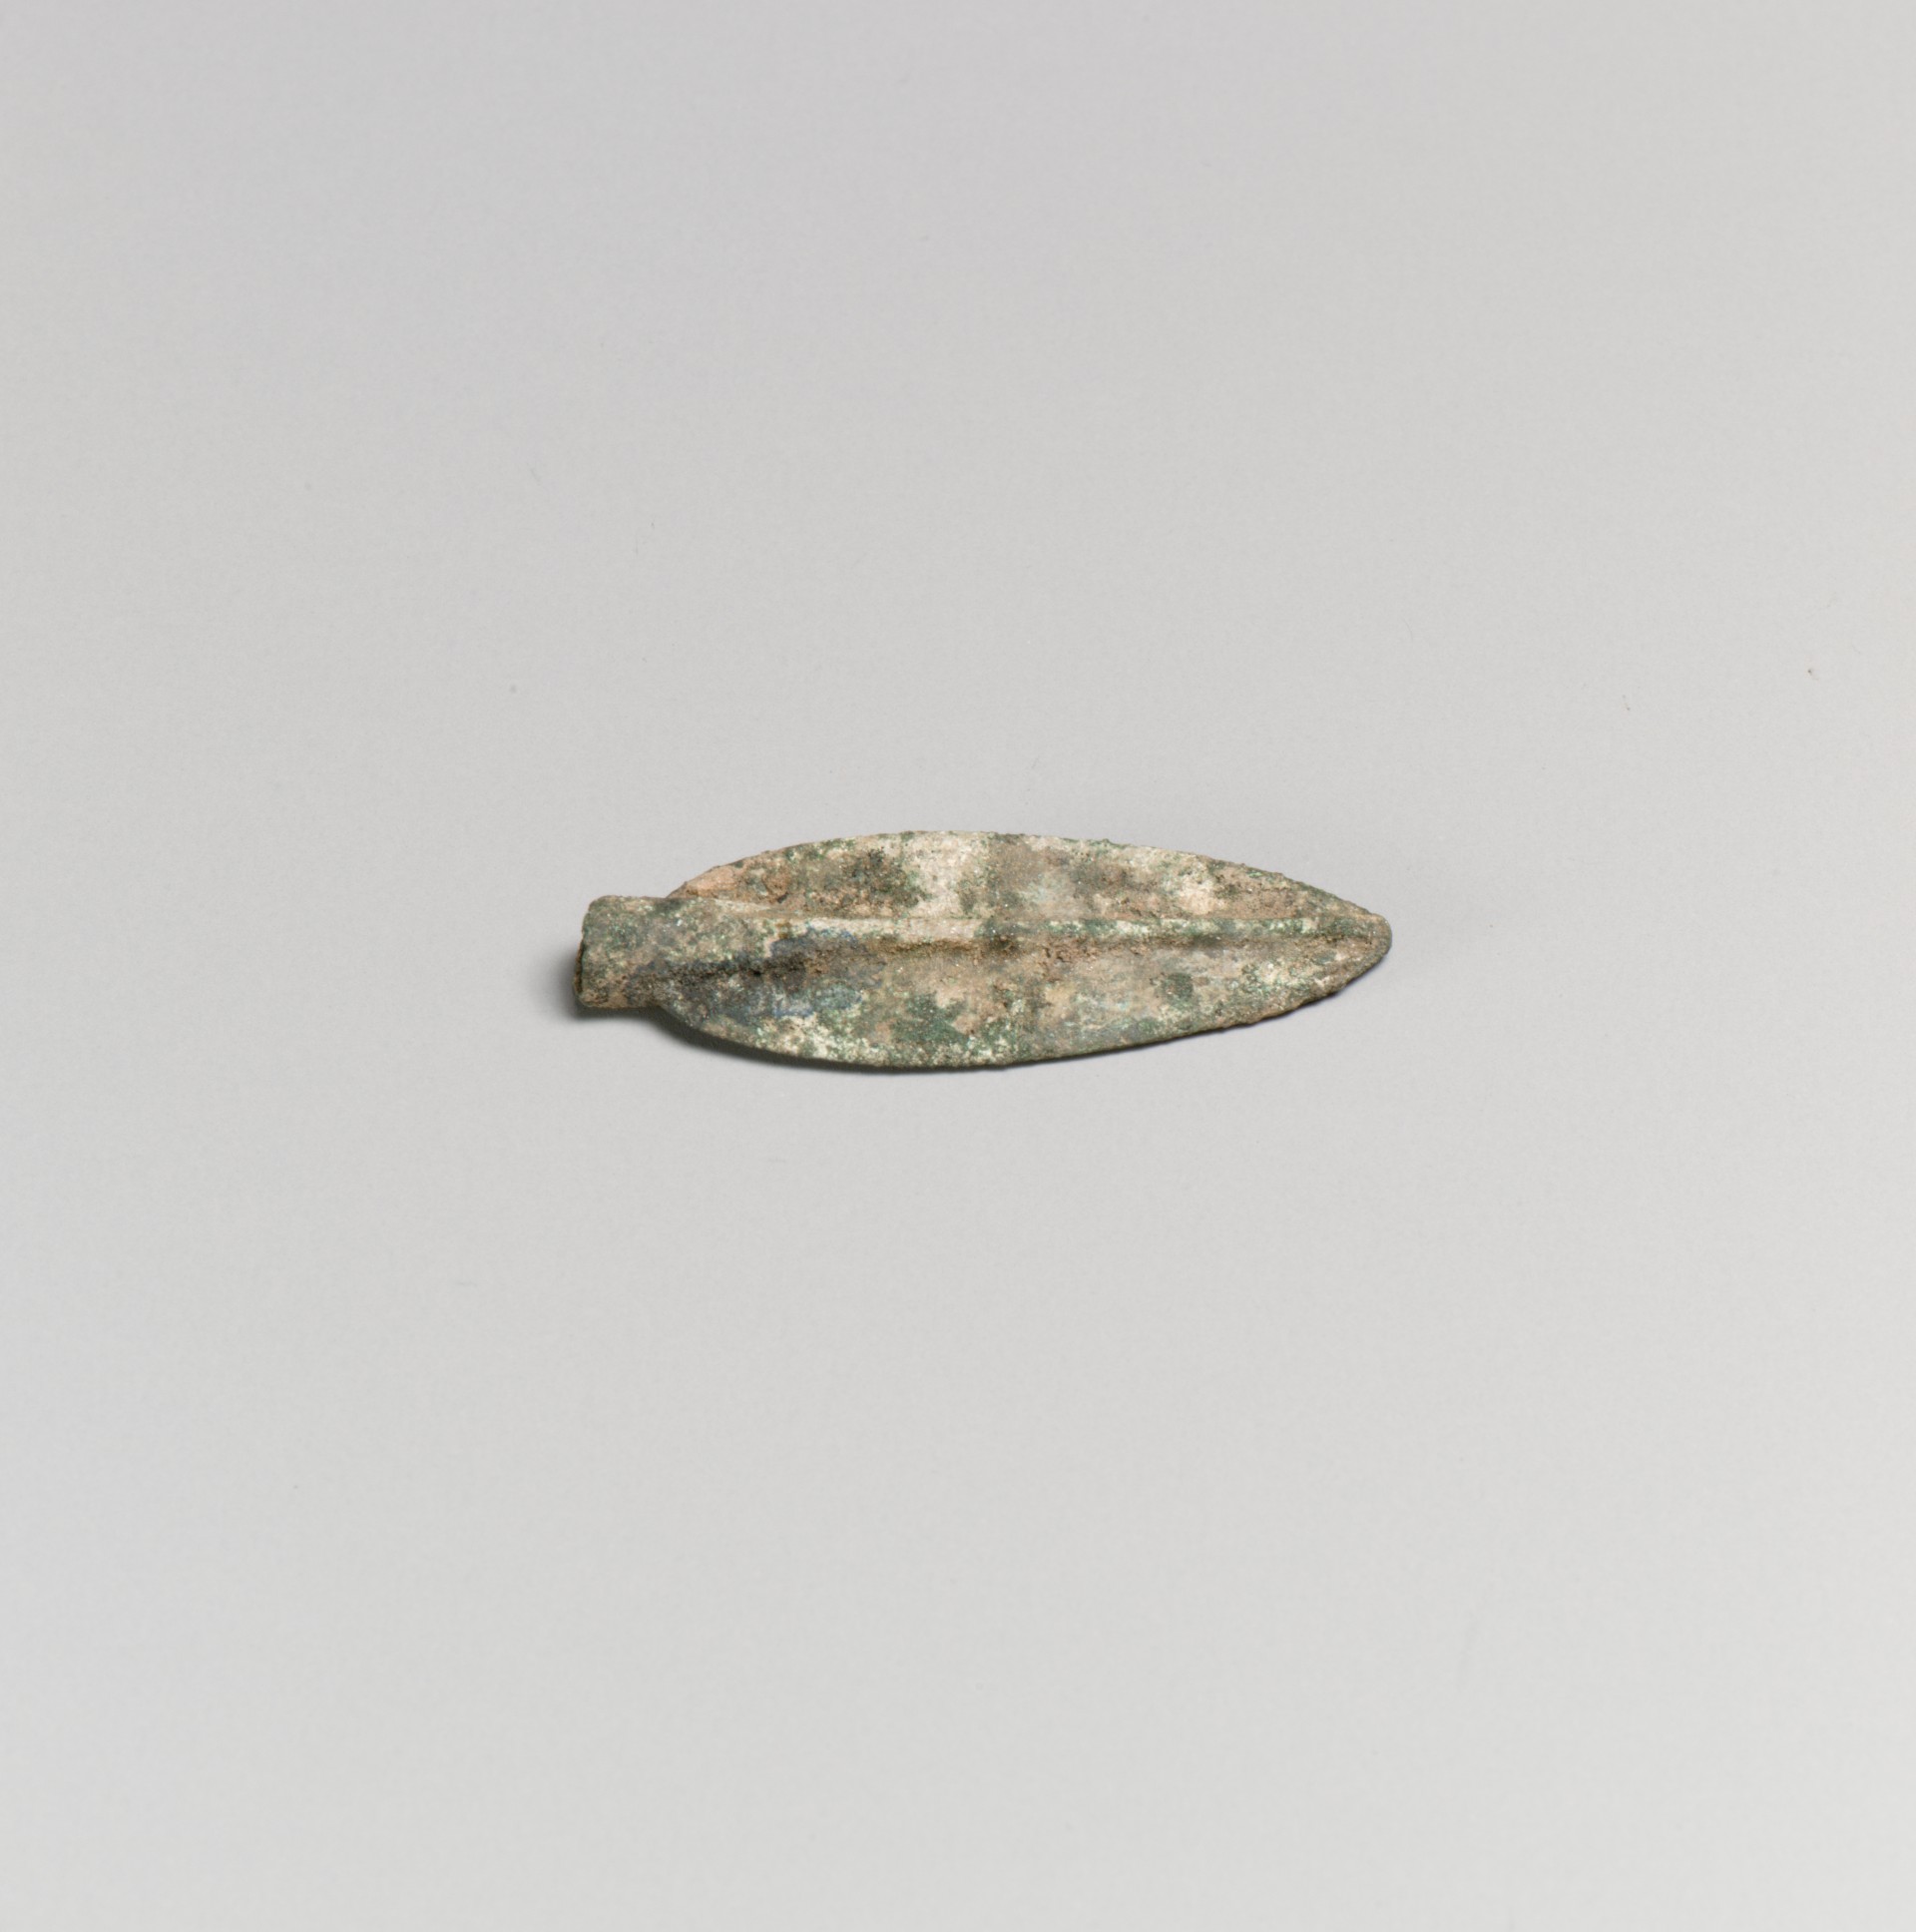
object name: arrowhead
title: Bronze arrowhead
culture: achaemenid or greek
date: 400-501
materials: bronze